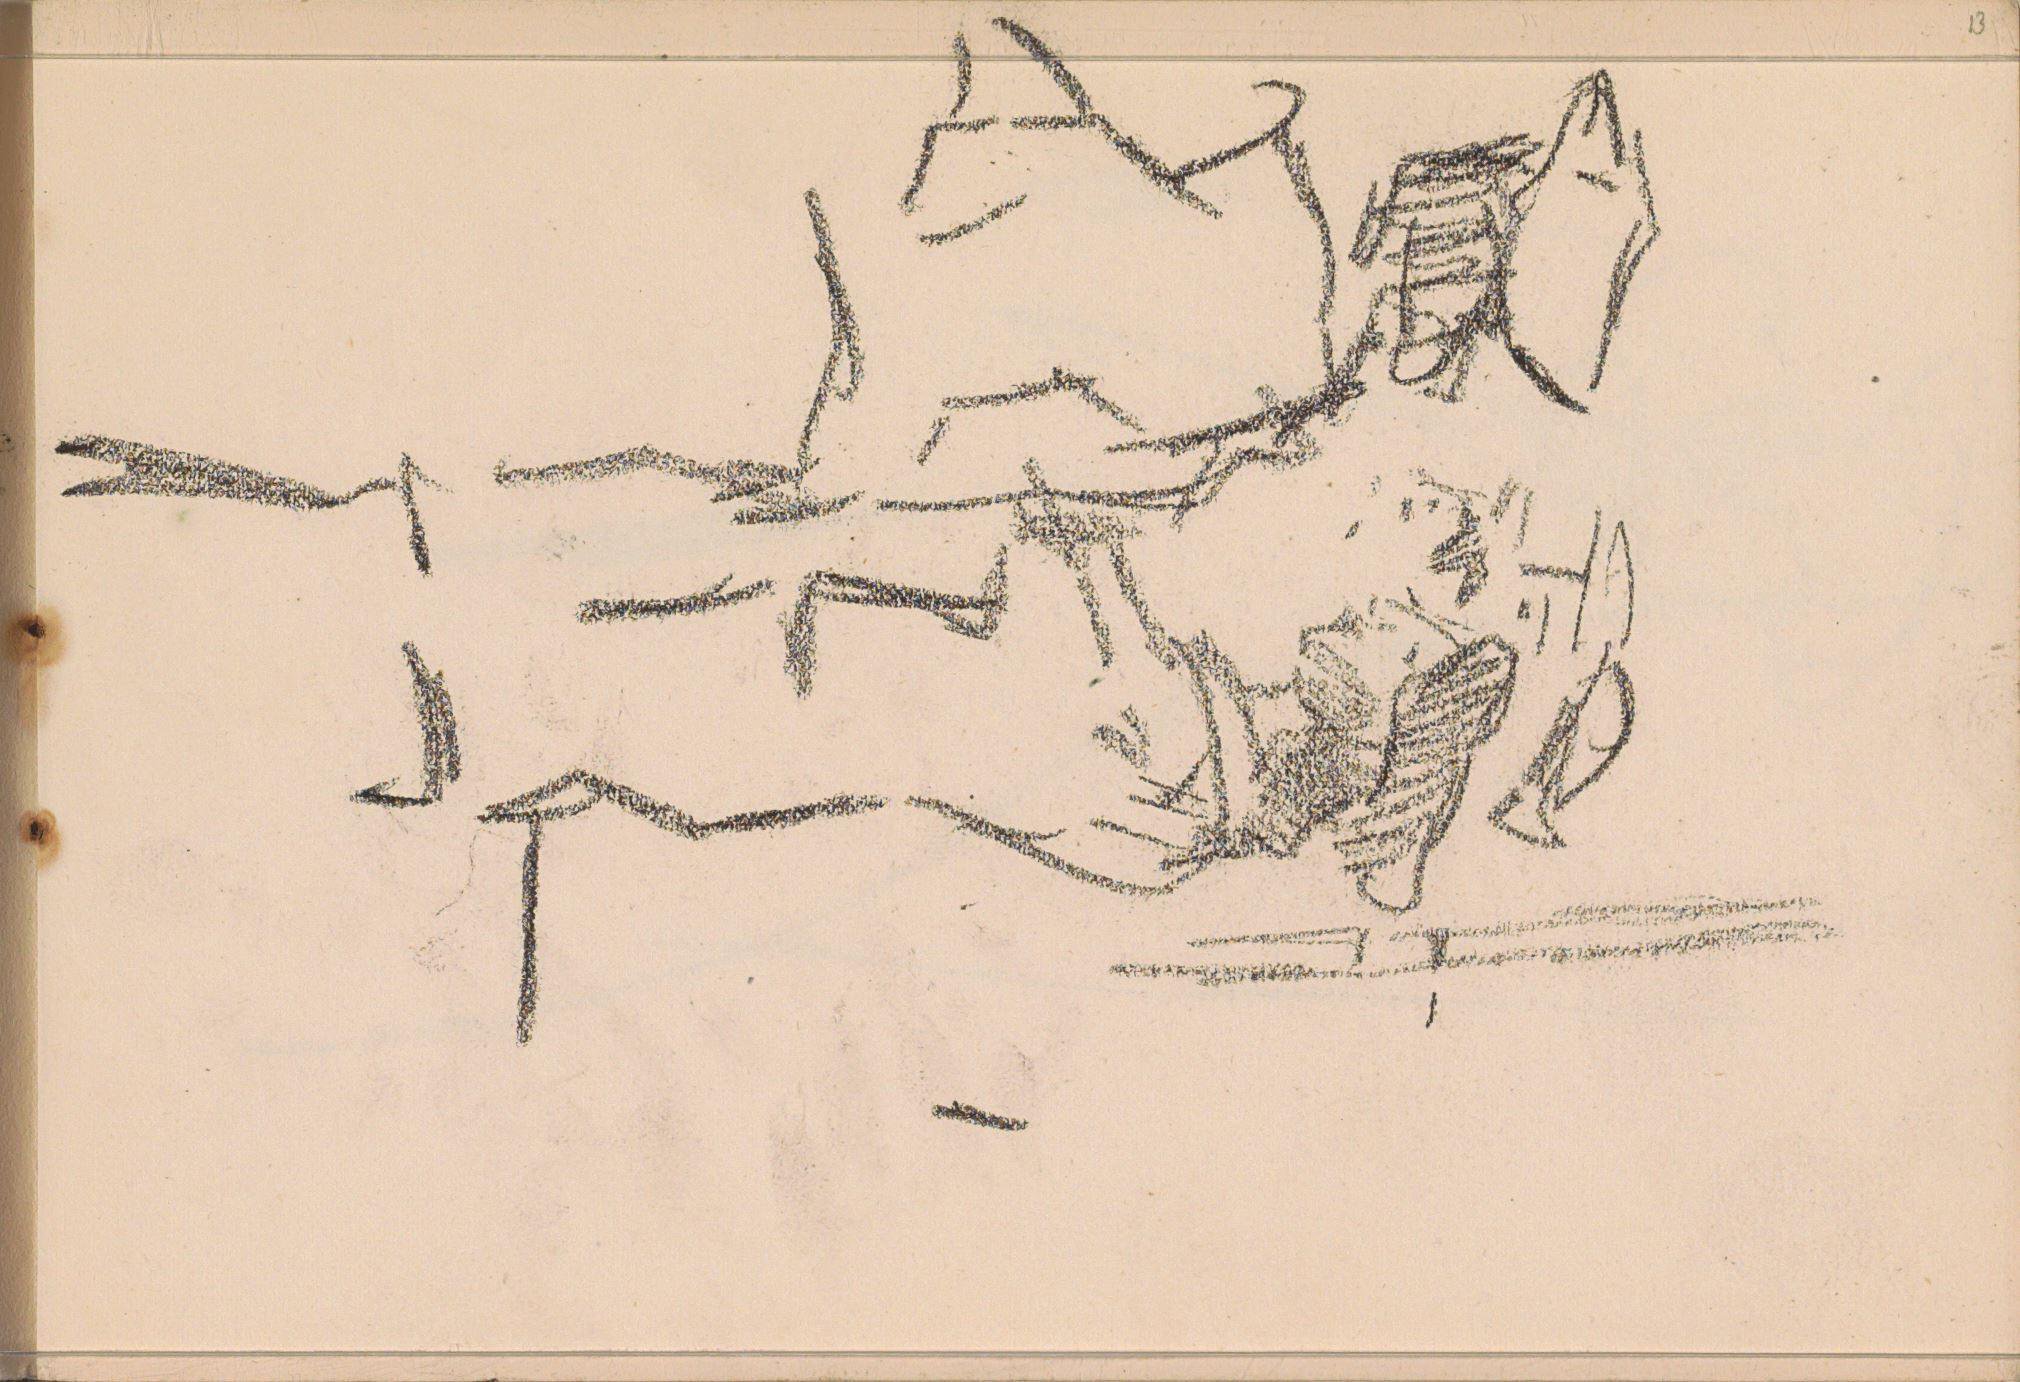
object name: sketchbook leaf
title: Vier figuren met hoofddeksels, in profiel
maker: isaac israels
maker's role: draughtsman, painter, print maker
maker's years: 1865-1934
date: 1875-1934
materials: chalk, paper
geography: the hague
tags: head-gear, the (nude) human figure; 'corpo humano' (ripa) (+ standing)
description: Pagina 13 uit schetsboek XLII met 32 pagina's.